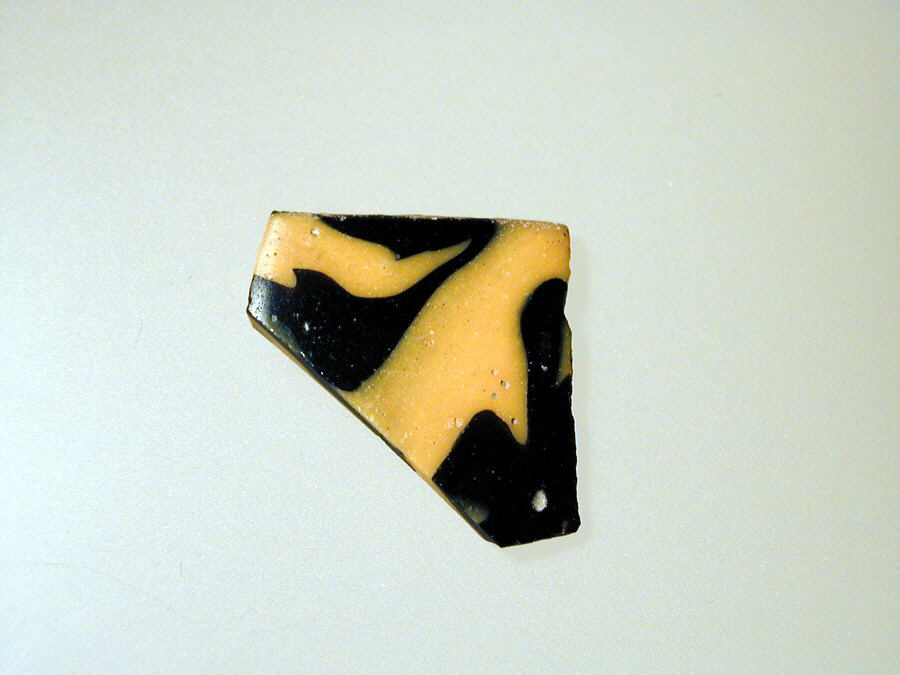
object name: fragment, mosaic bowl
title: Glass mosaic bowl fragment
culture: roman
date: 34 BCE-33 CE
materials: glass